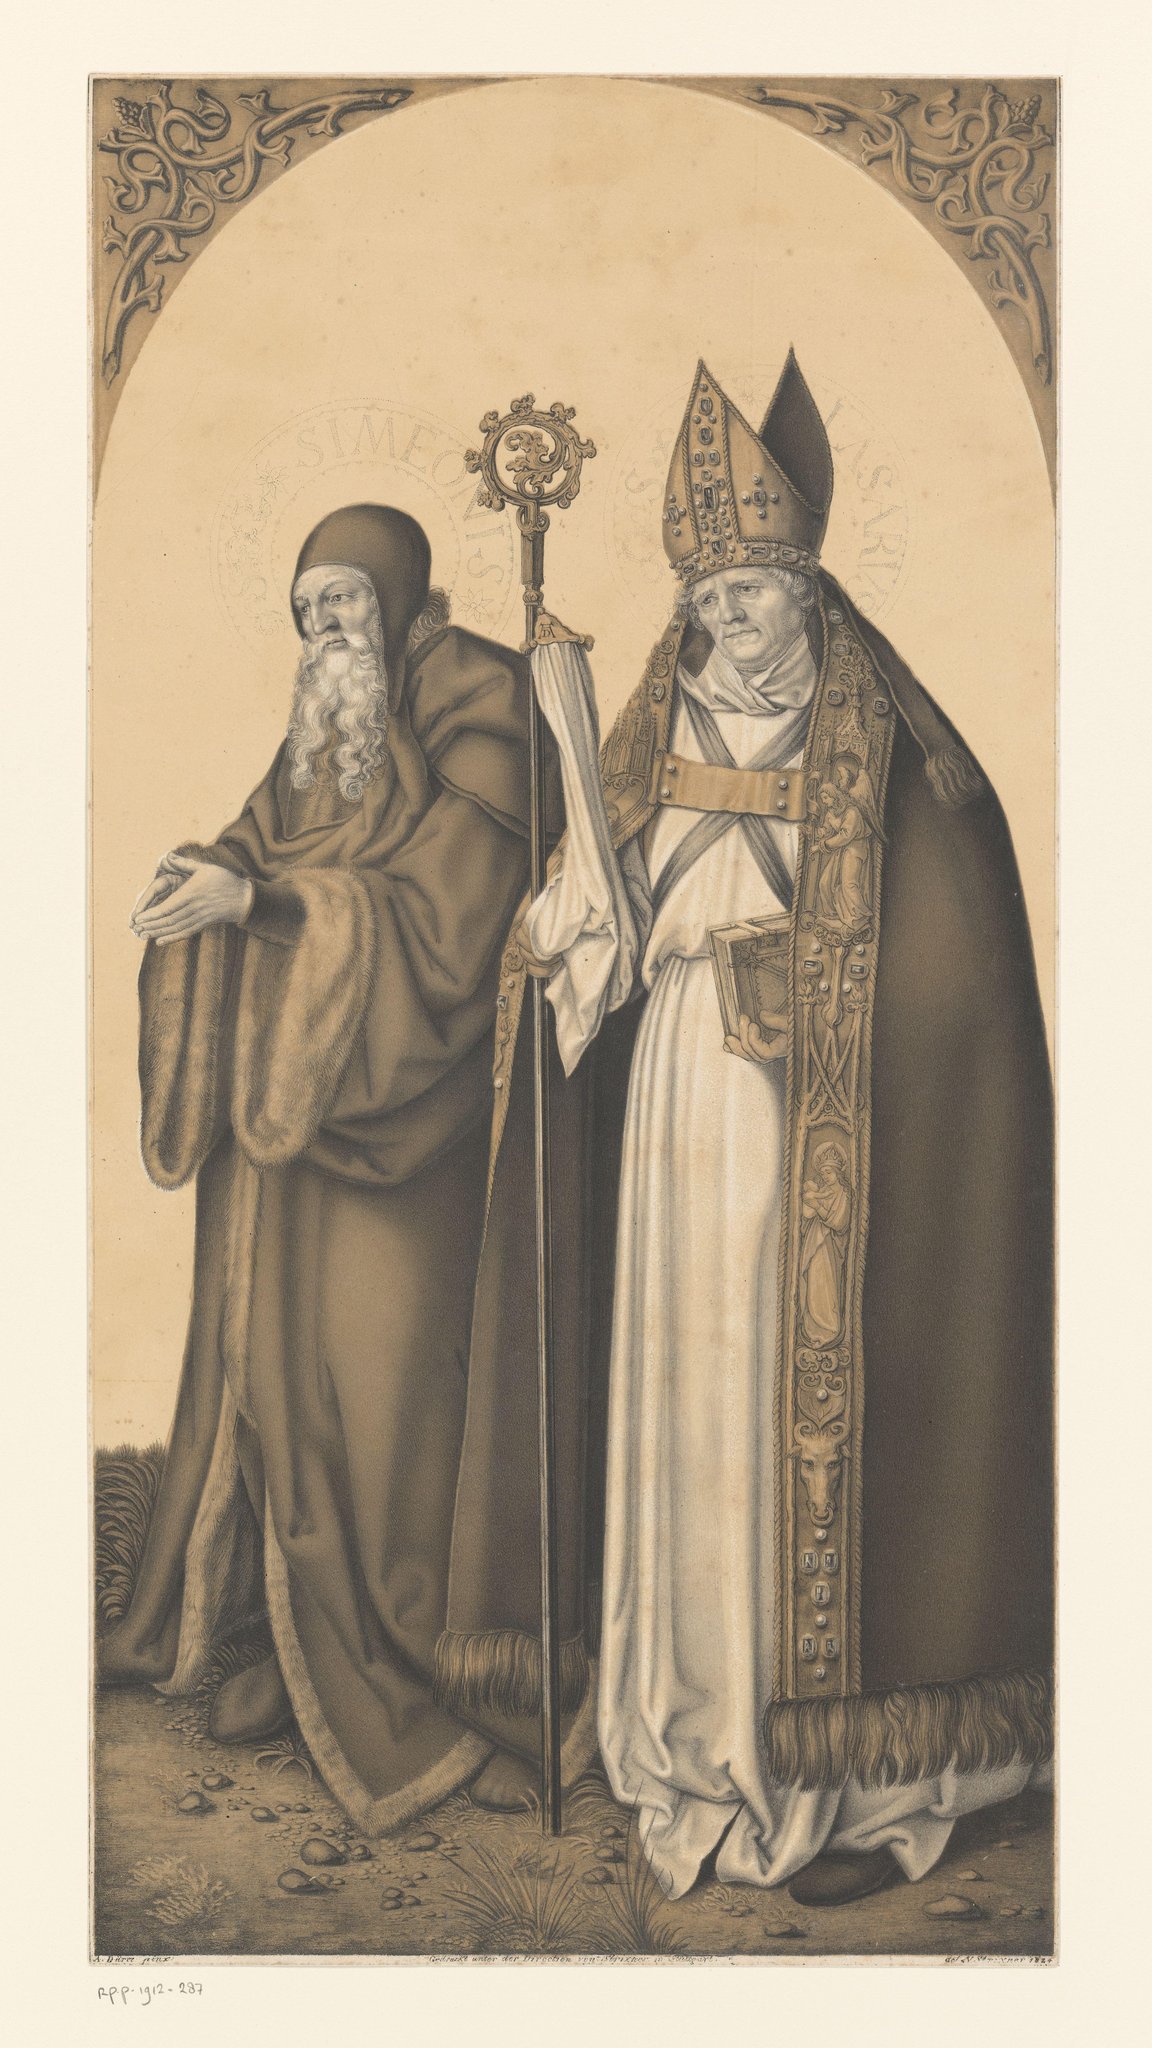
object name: print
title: Werken uit de collectie van de broers Boisserée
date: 1824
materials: paper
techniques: tone lithography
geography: stuttgart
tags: the apostle simon zelotes (or simon the canaanite); possible attributes: book, saw, scroll, the brother of st. martha and st. mary magdalene, lazarus of bethany, bishop of marseilles; possible attributes: bishop's garment, book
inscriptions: collector's mark: Lugt 2228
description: Deze prent behoort tot de serie 'Galerie des Frères Boisserée'. De serie is in 38 delen uitgegeven met drie prenten per deel en nog drie extra inleidende prenten. Deze prent verscheen in het dertiende deel.